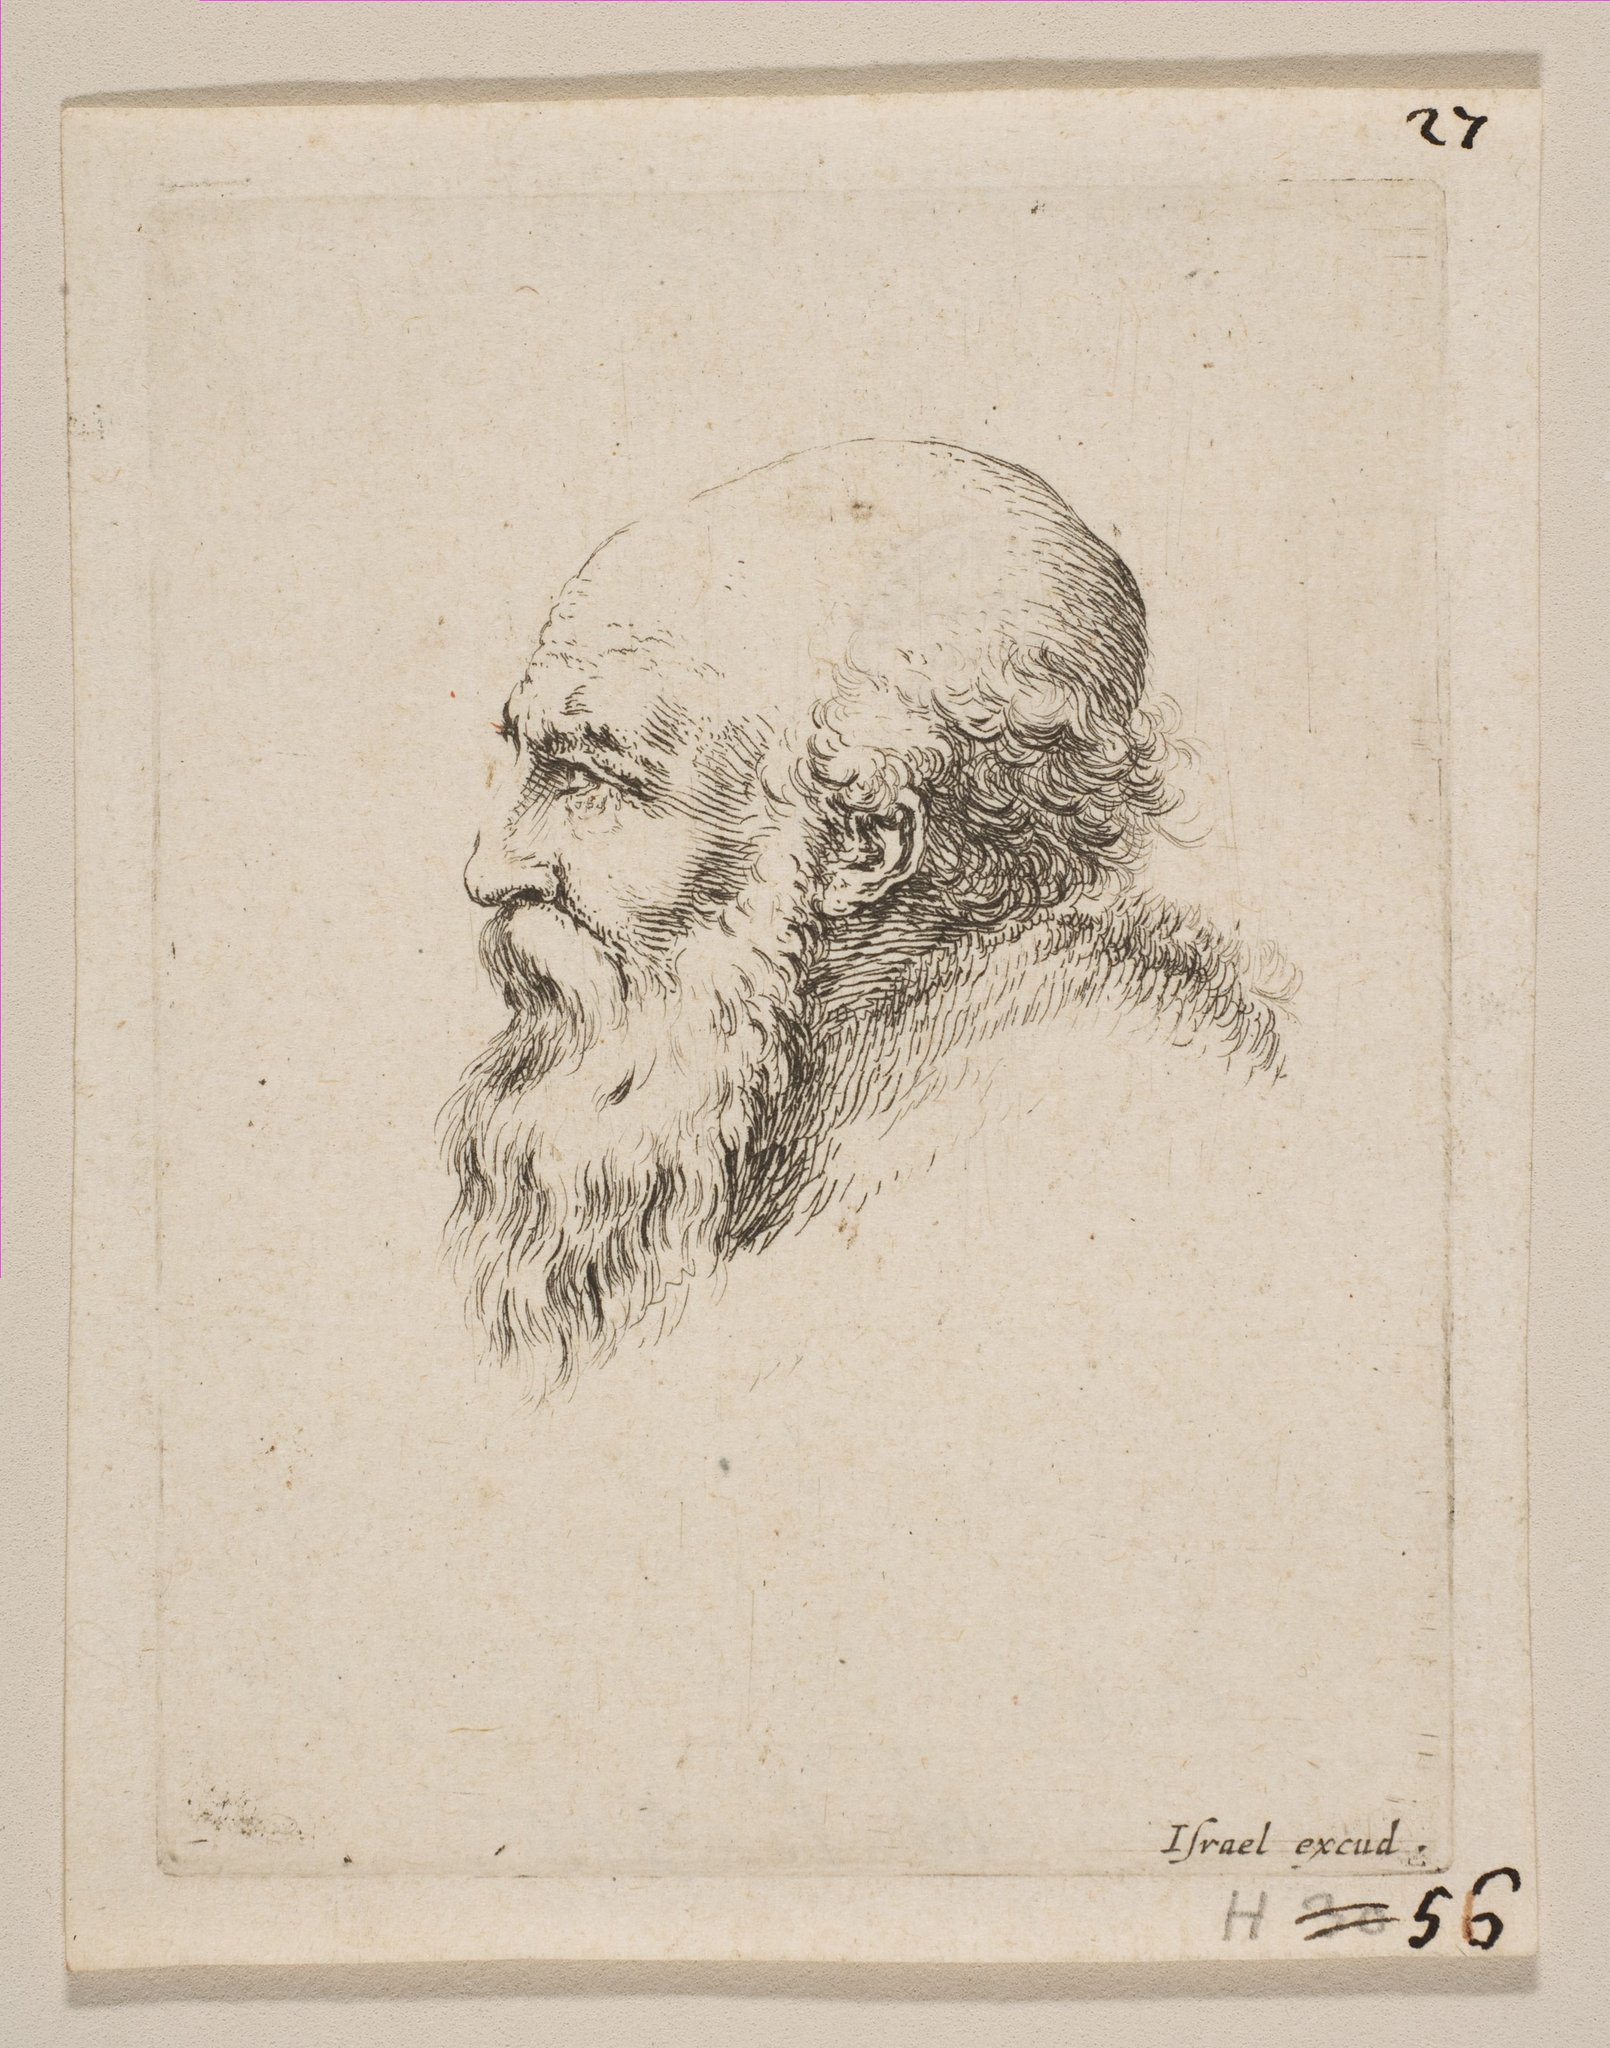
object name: print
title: Head of a Bald and Bearded Old Man in Profile, from 'Various heads and figures' (Diverses tétes et figures)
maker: stefano della bella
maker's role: artist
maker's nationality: italian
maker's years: 1610-1664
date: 1650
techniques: etching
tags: men,profiles